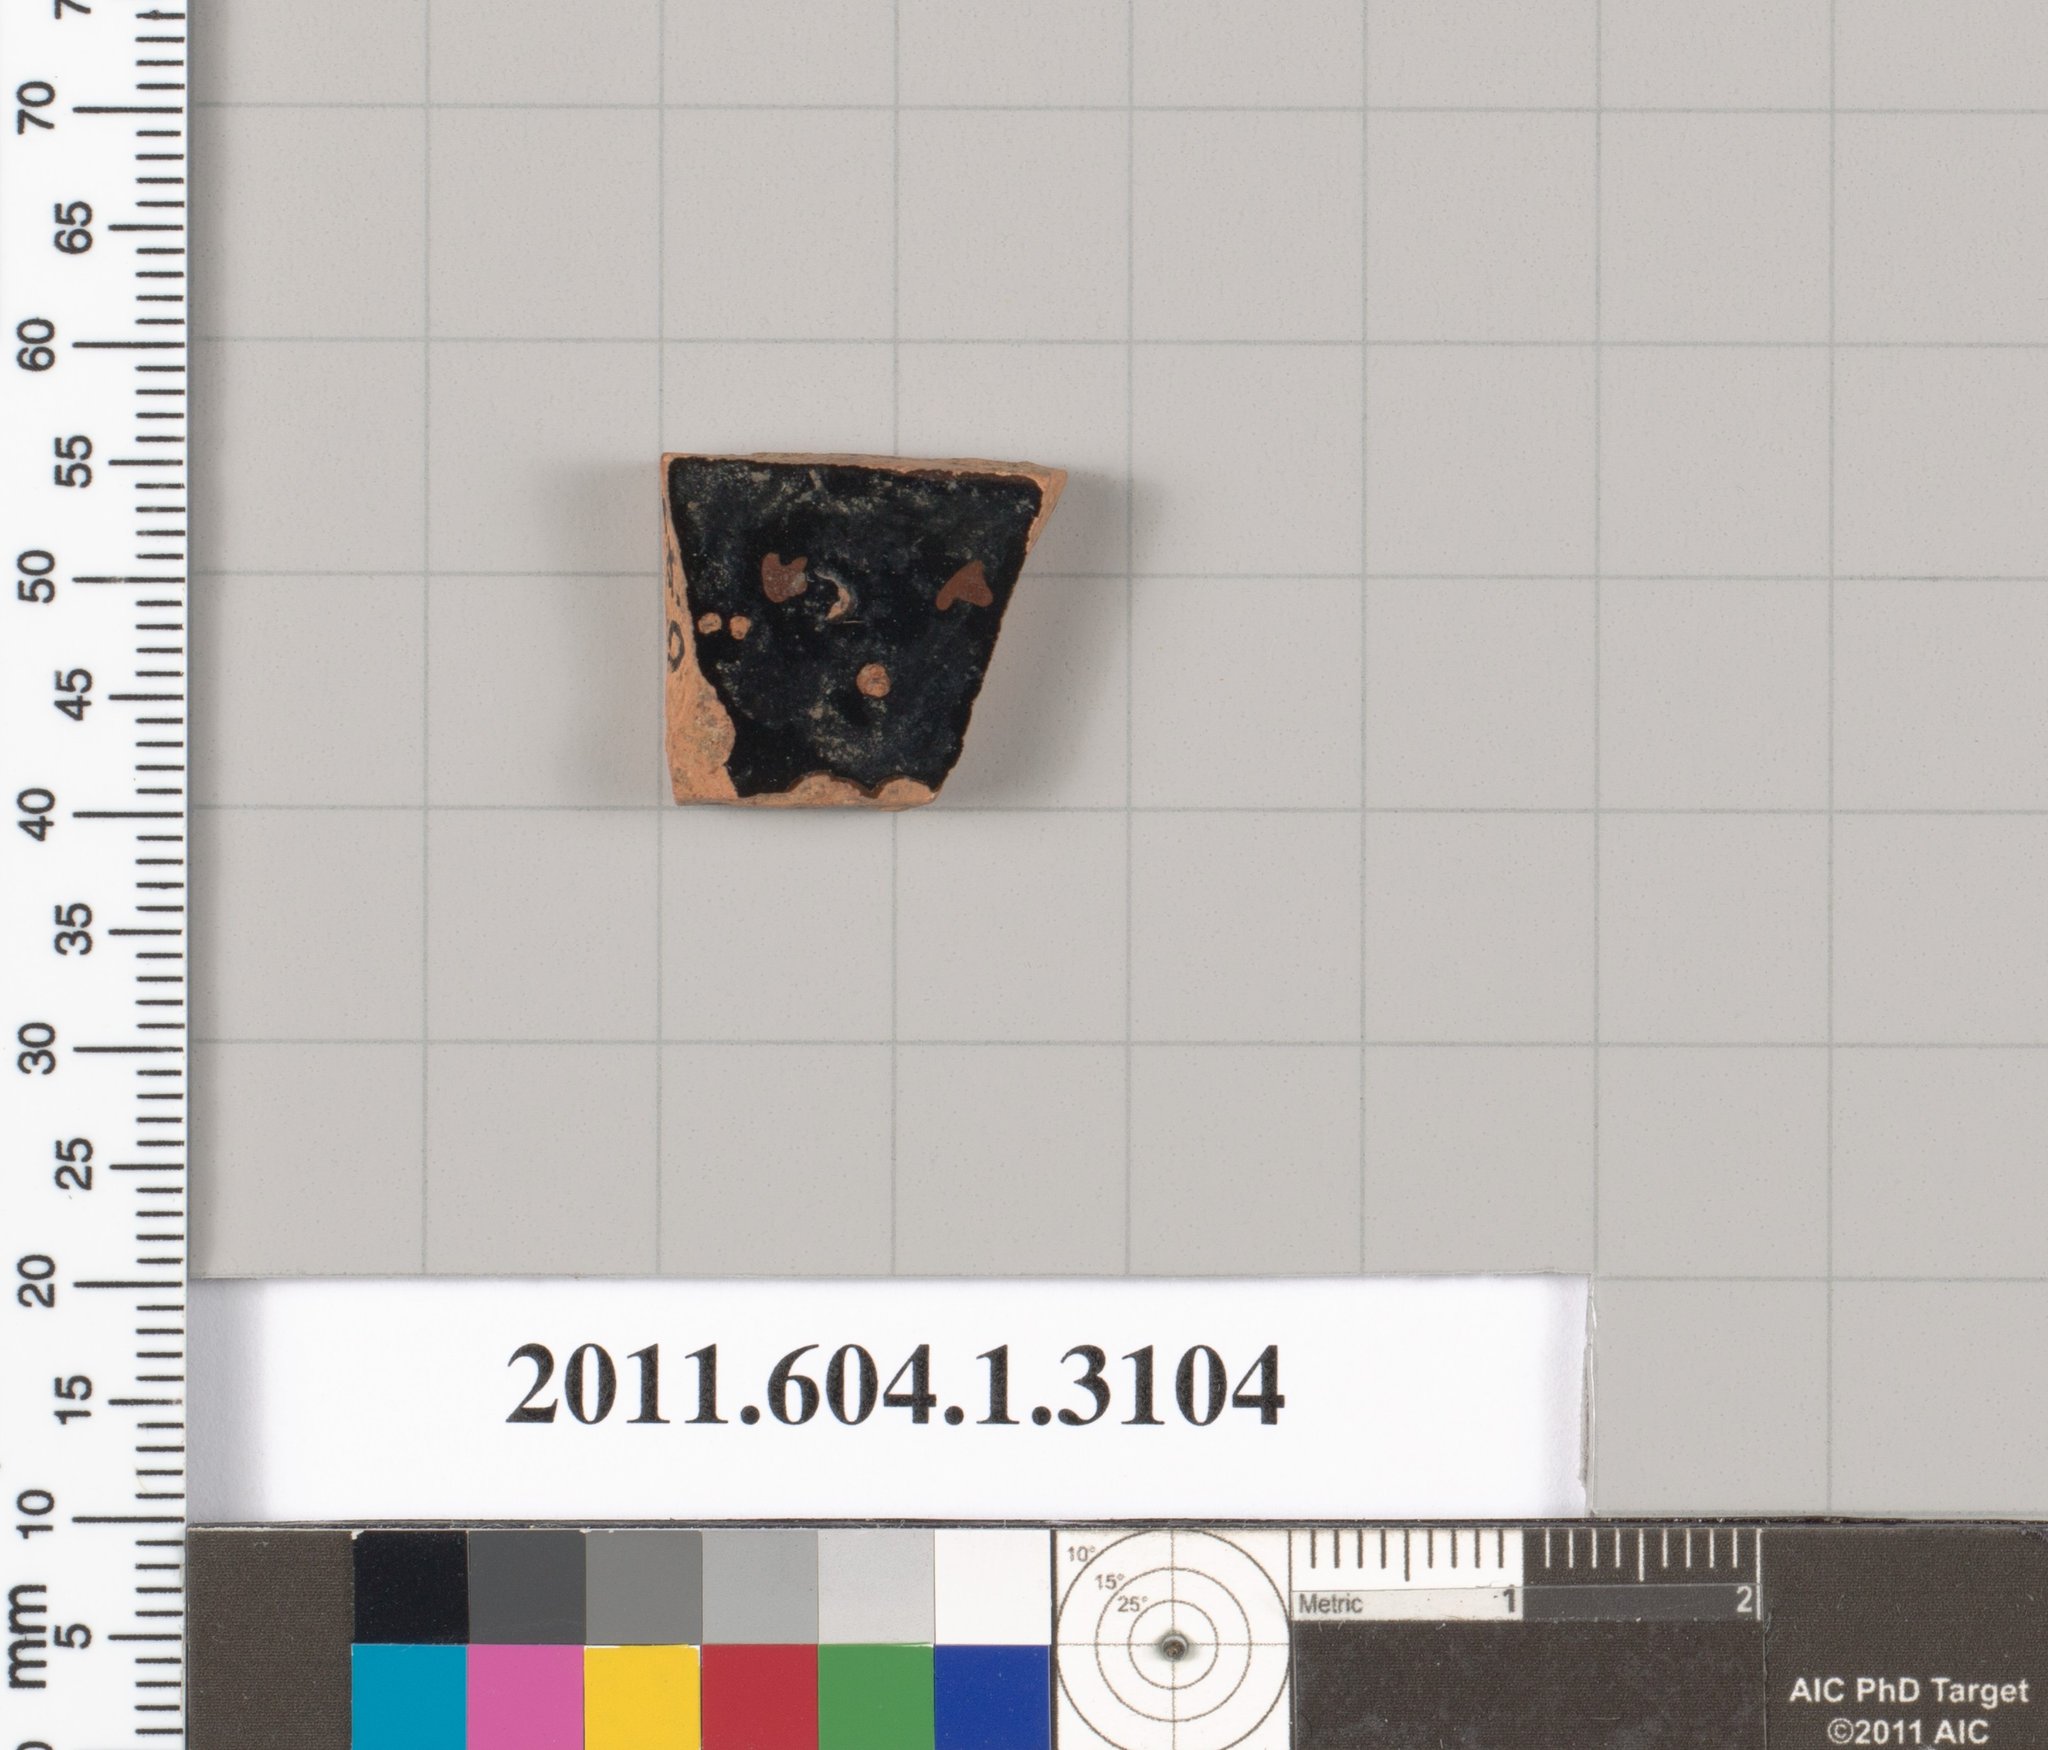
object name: kylix fragment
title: Terracotta fragment of a kylix (drinking cup)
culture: greek, attic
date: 500-480 BCE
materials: terracotta